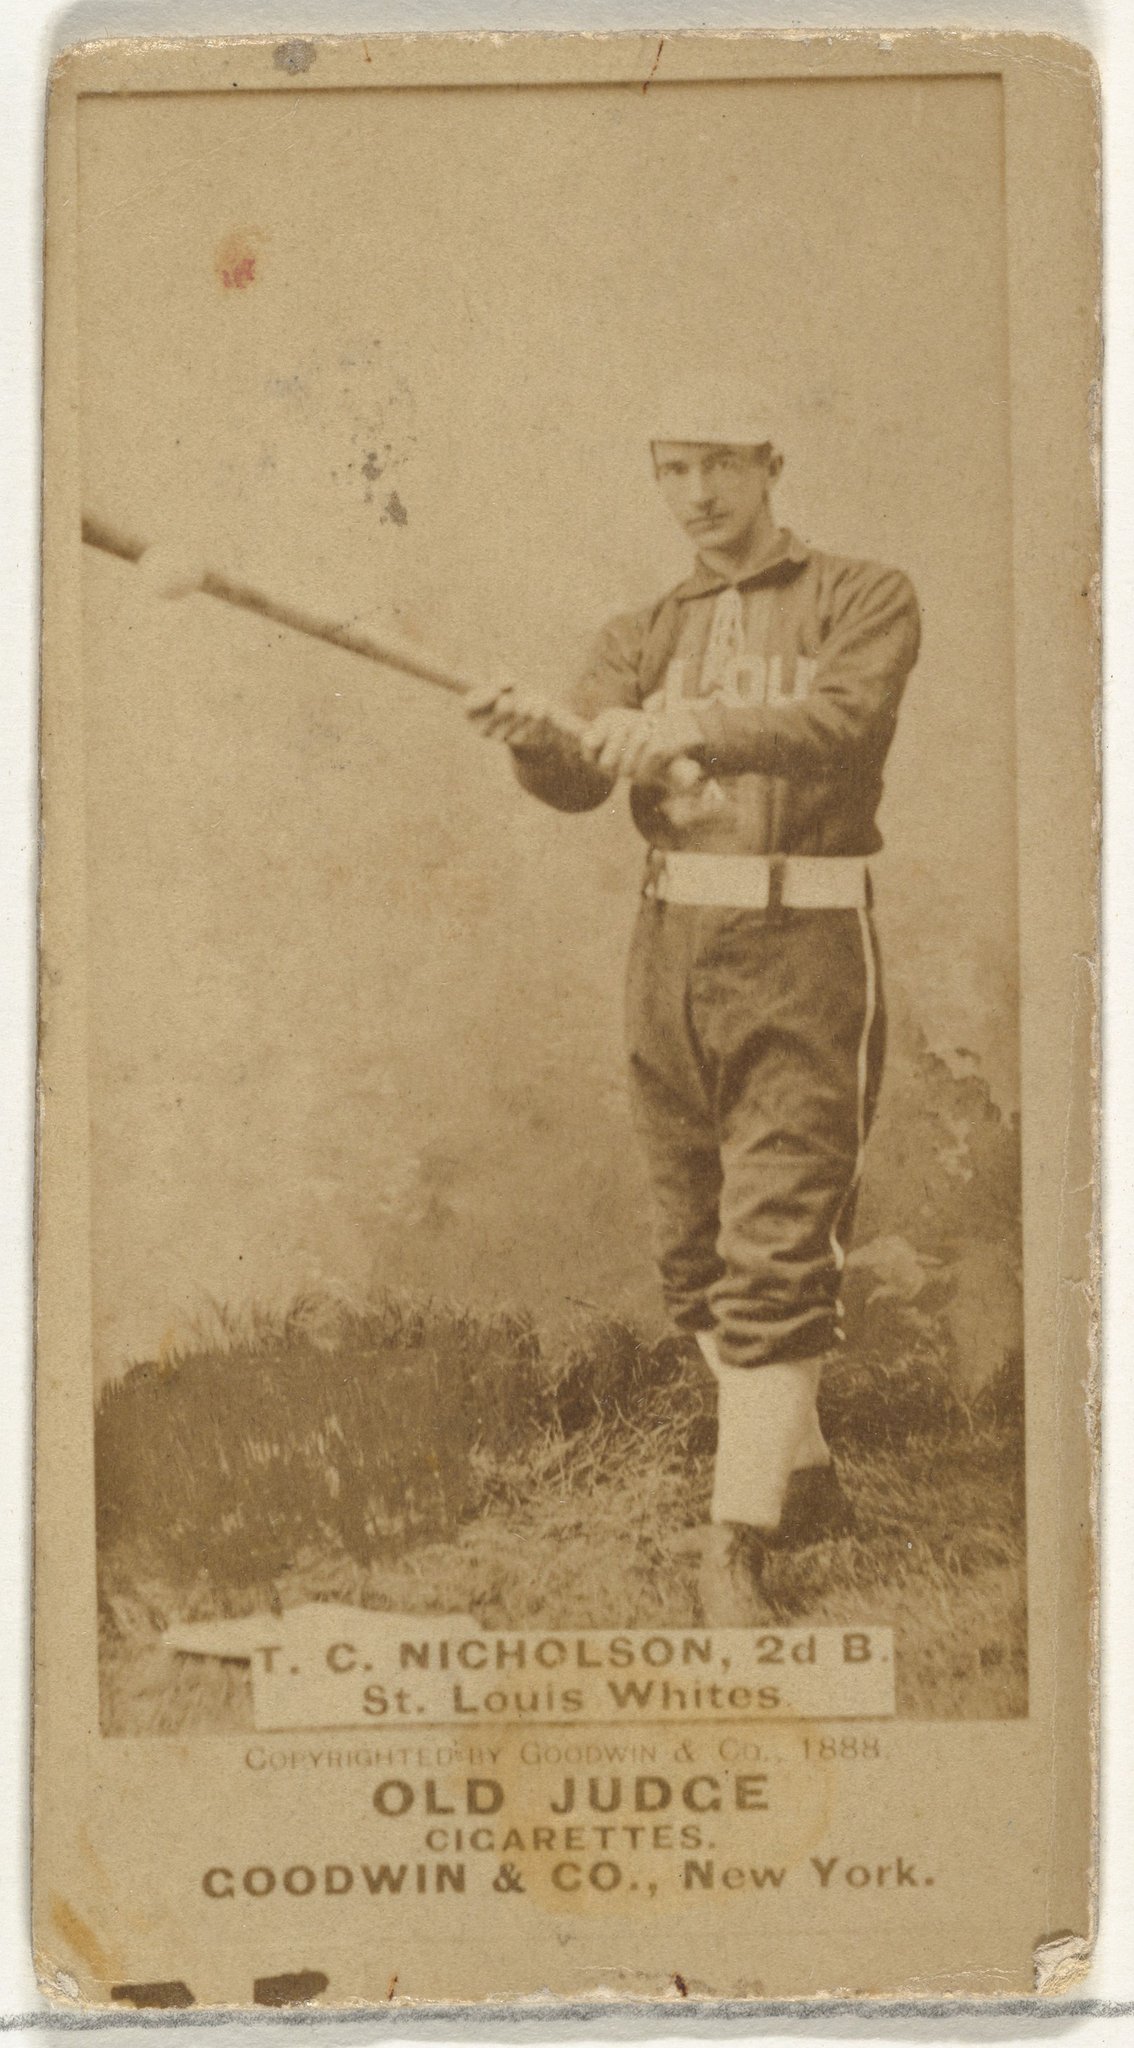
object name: baseball card, photograph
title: Nicholson, 2nd Base, St. Louis Whites, from the Old Judge series (N172) for Old Judge Cigarettes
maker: goodwin & company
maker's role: publisher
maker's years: 1850-1950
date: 1888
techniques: albumen silver print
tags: men,portraits,baseball,athletes